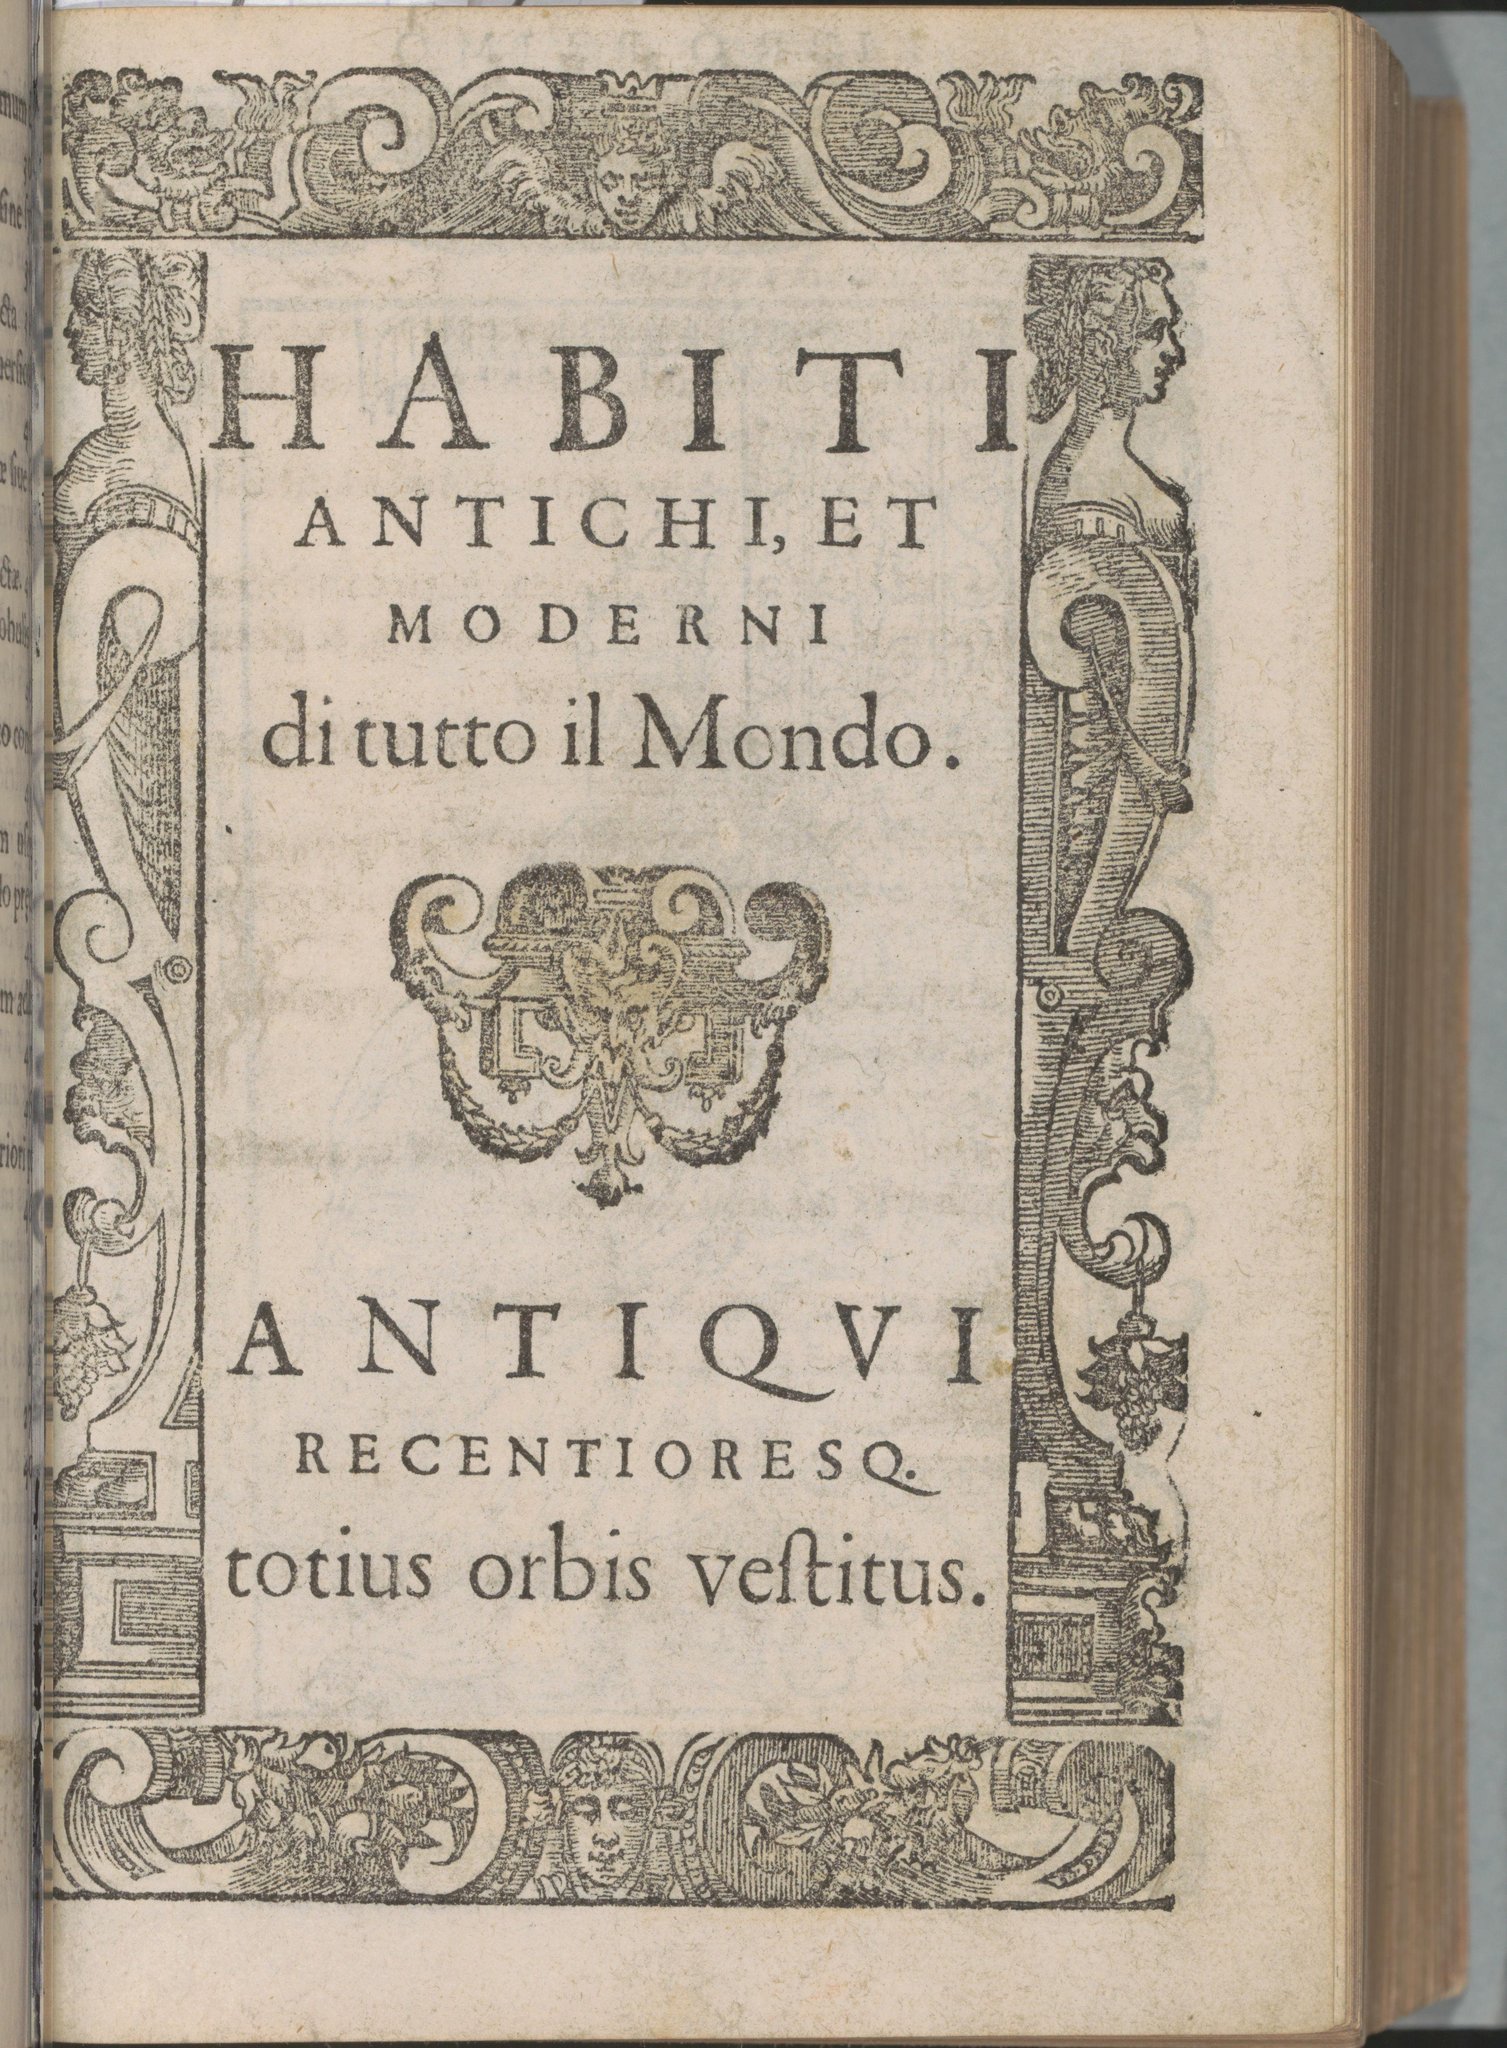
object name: album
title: Habiti antichi, et moderni di tutto il mondo : di nuovo accresciuti di molte figure : vestitus antiquorum, recentiorumque totius orbis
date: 1598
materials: paper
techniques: letterpress printing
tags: fashion plates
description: Titelblad. De titel ' Habiti antichi, et moderni di tutto il Mondo. Antiqui recentioresq. totius orbis vestitus' is gevat in een ornamentrand